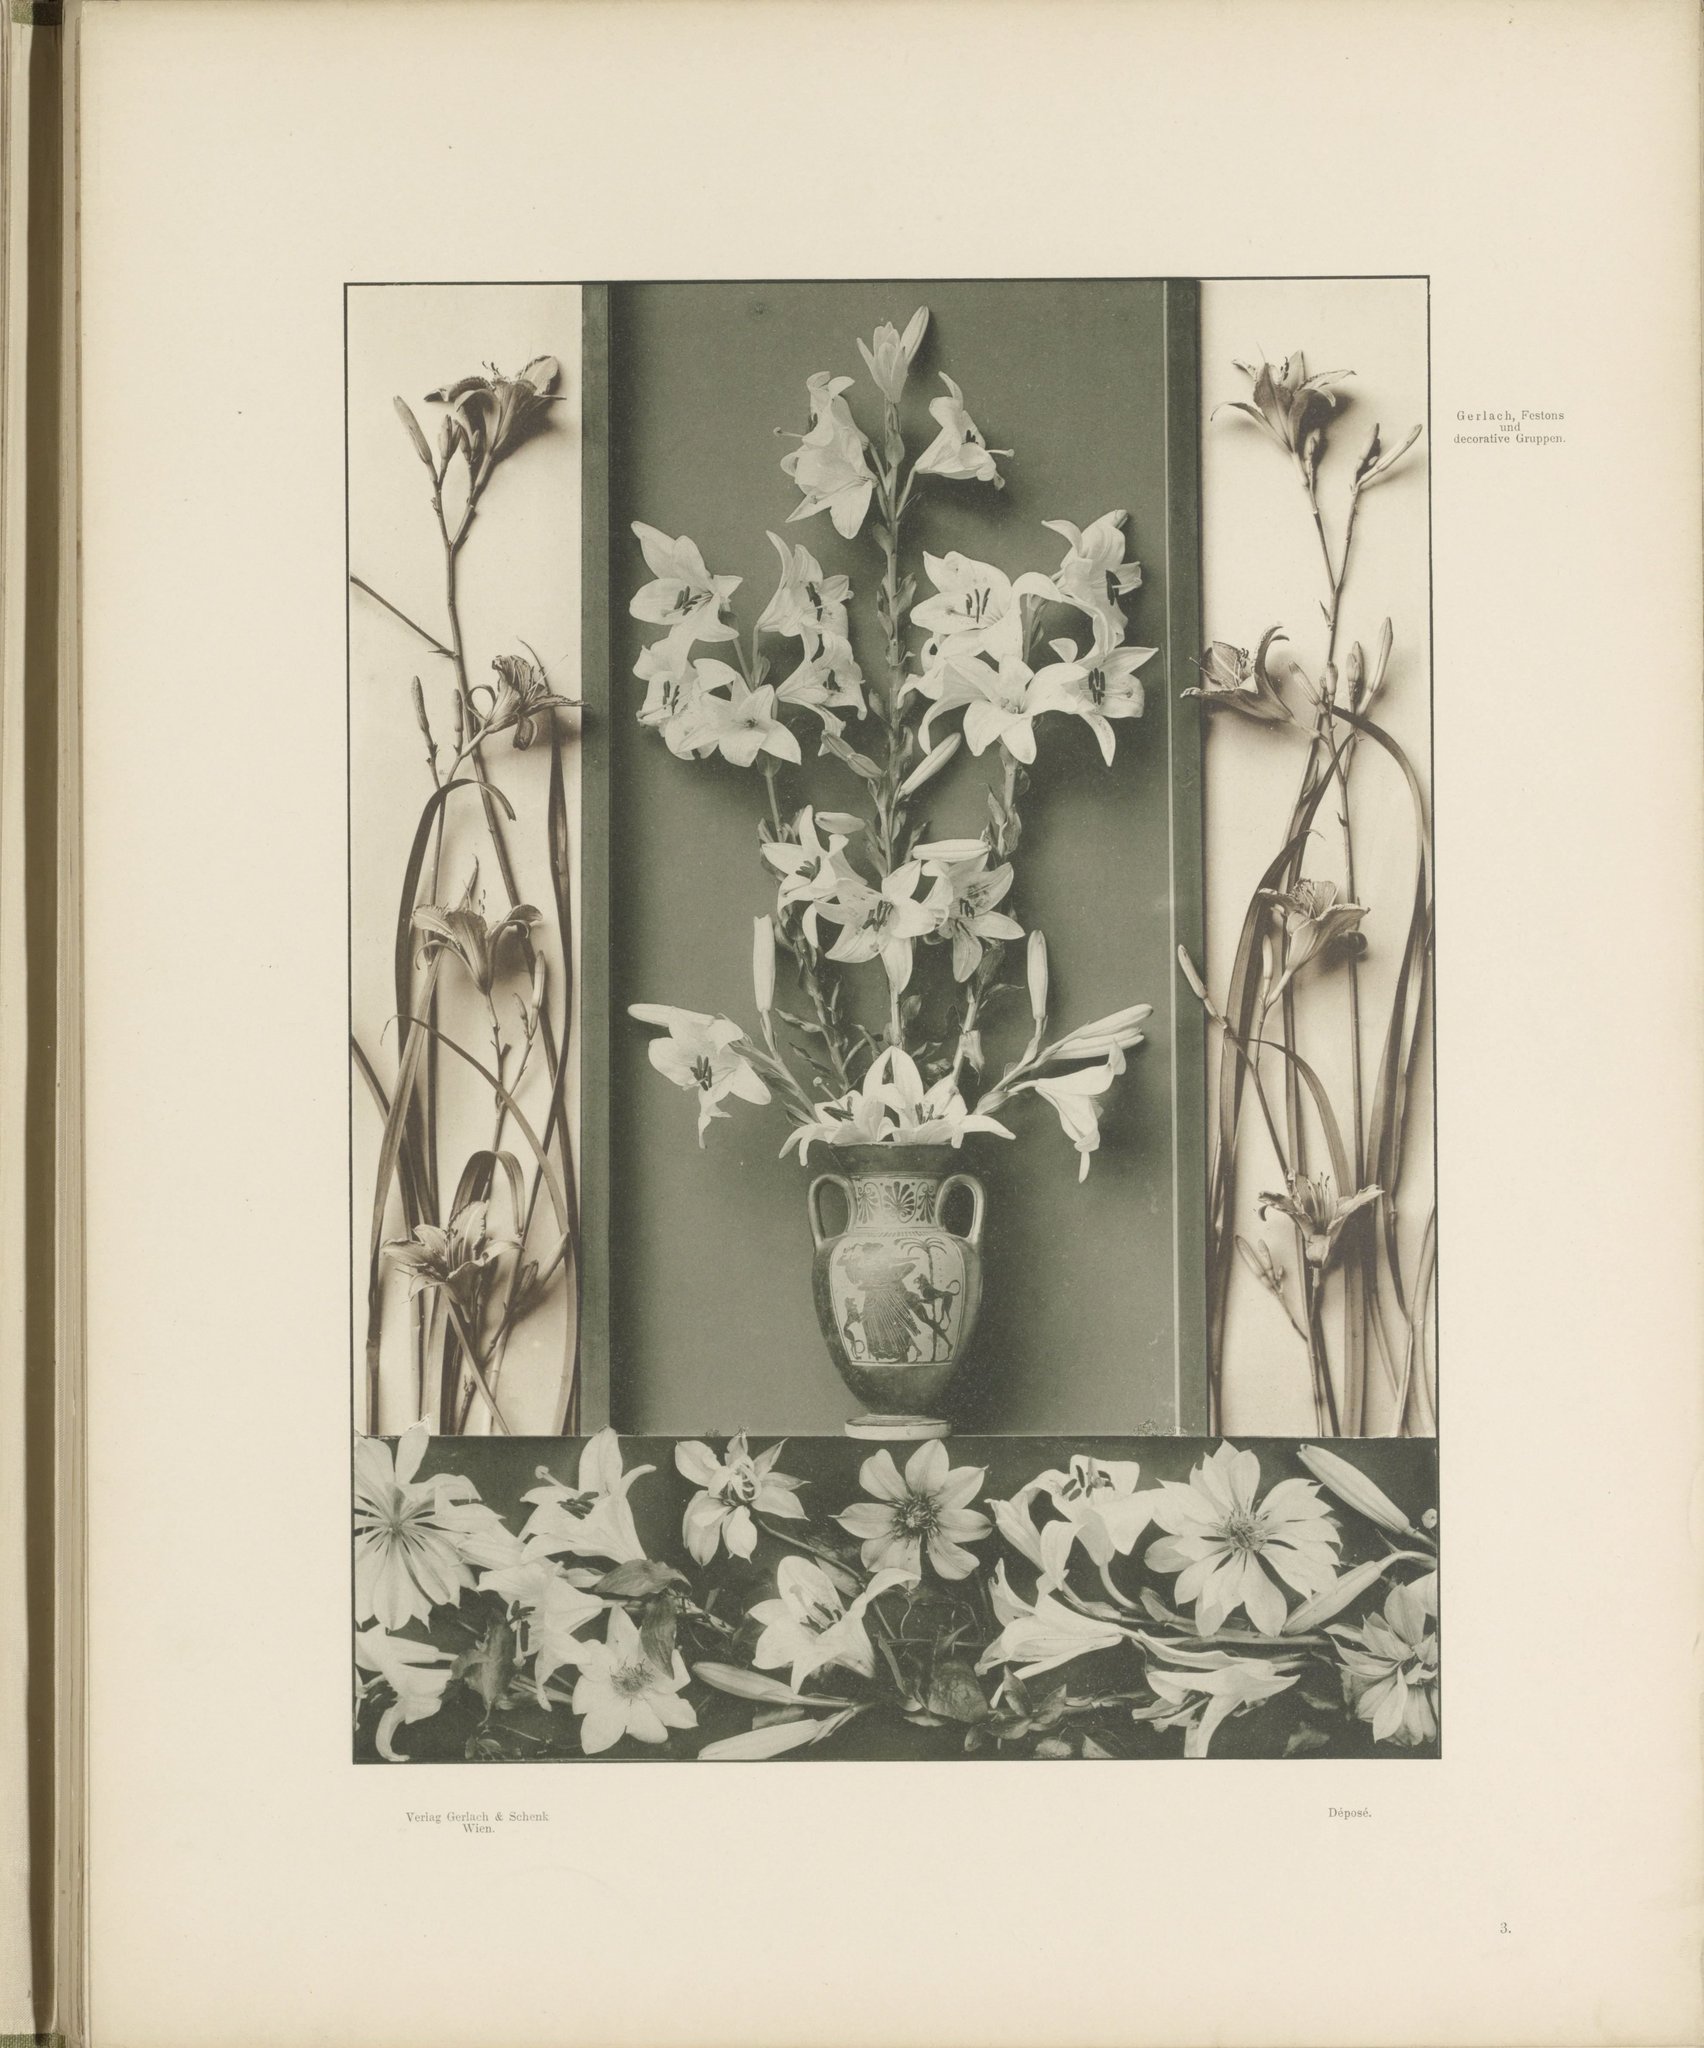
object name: page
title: Griekse vaas met lelies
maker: Anonymous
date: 1887-1897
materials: paper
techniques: photograph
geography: austria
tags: flowers: lily, flowers in a vase, container of stone: stone vase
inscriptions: number: ‘3.’